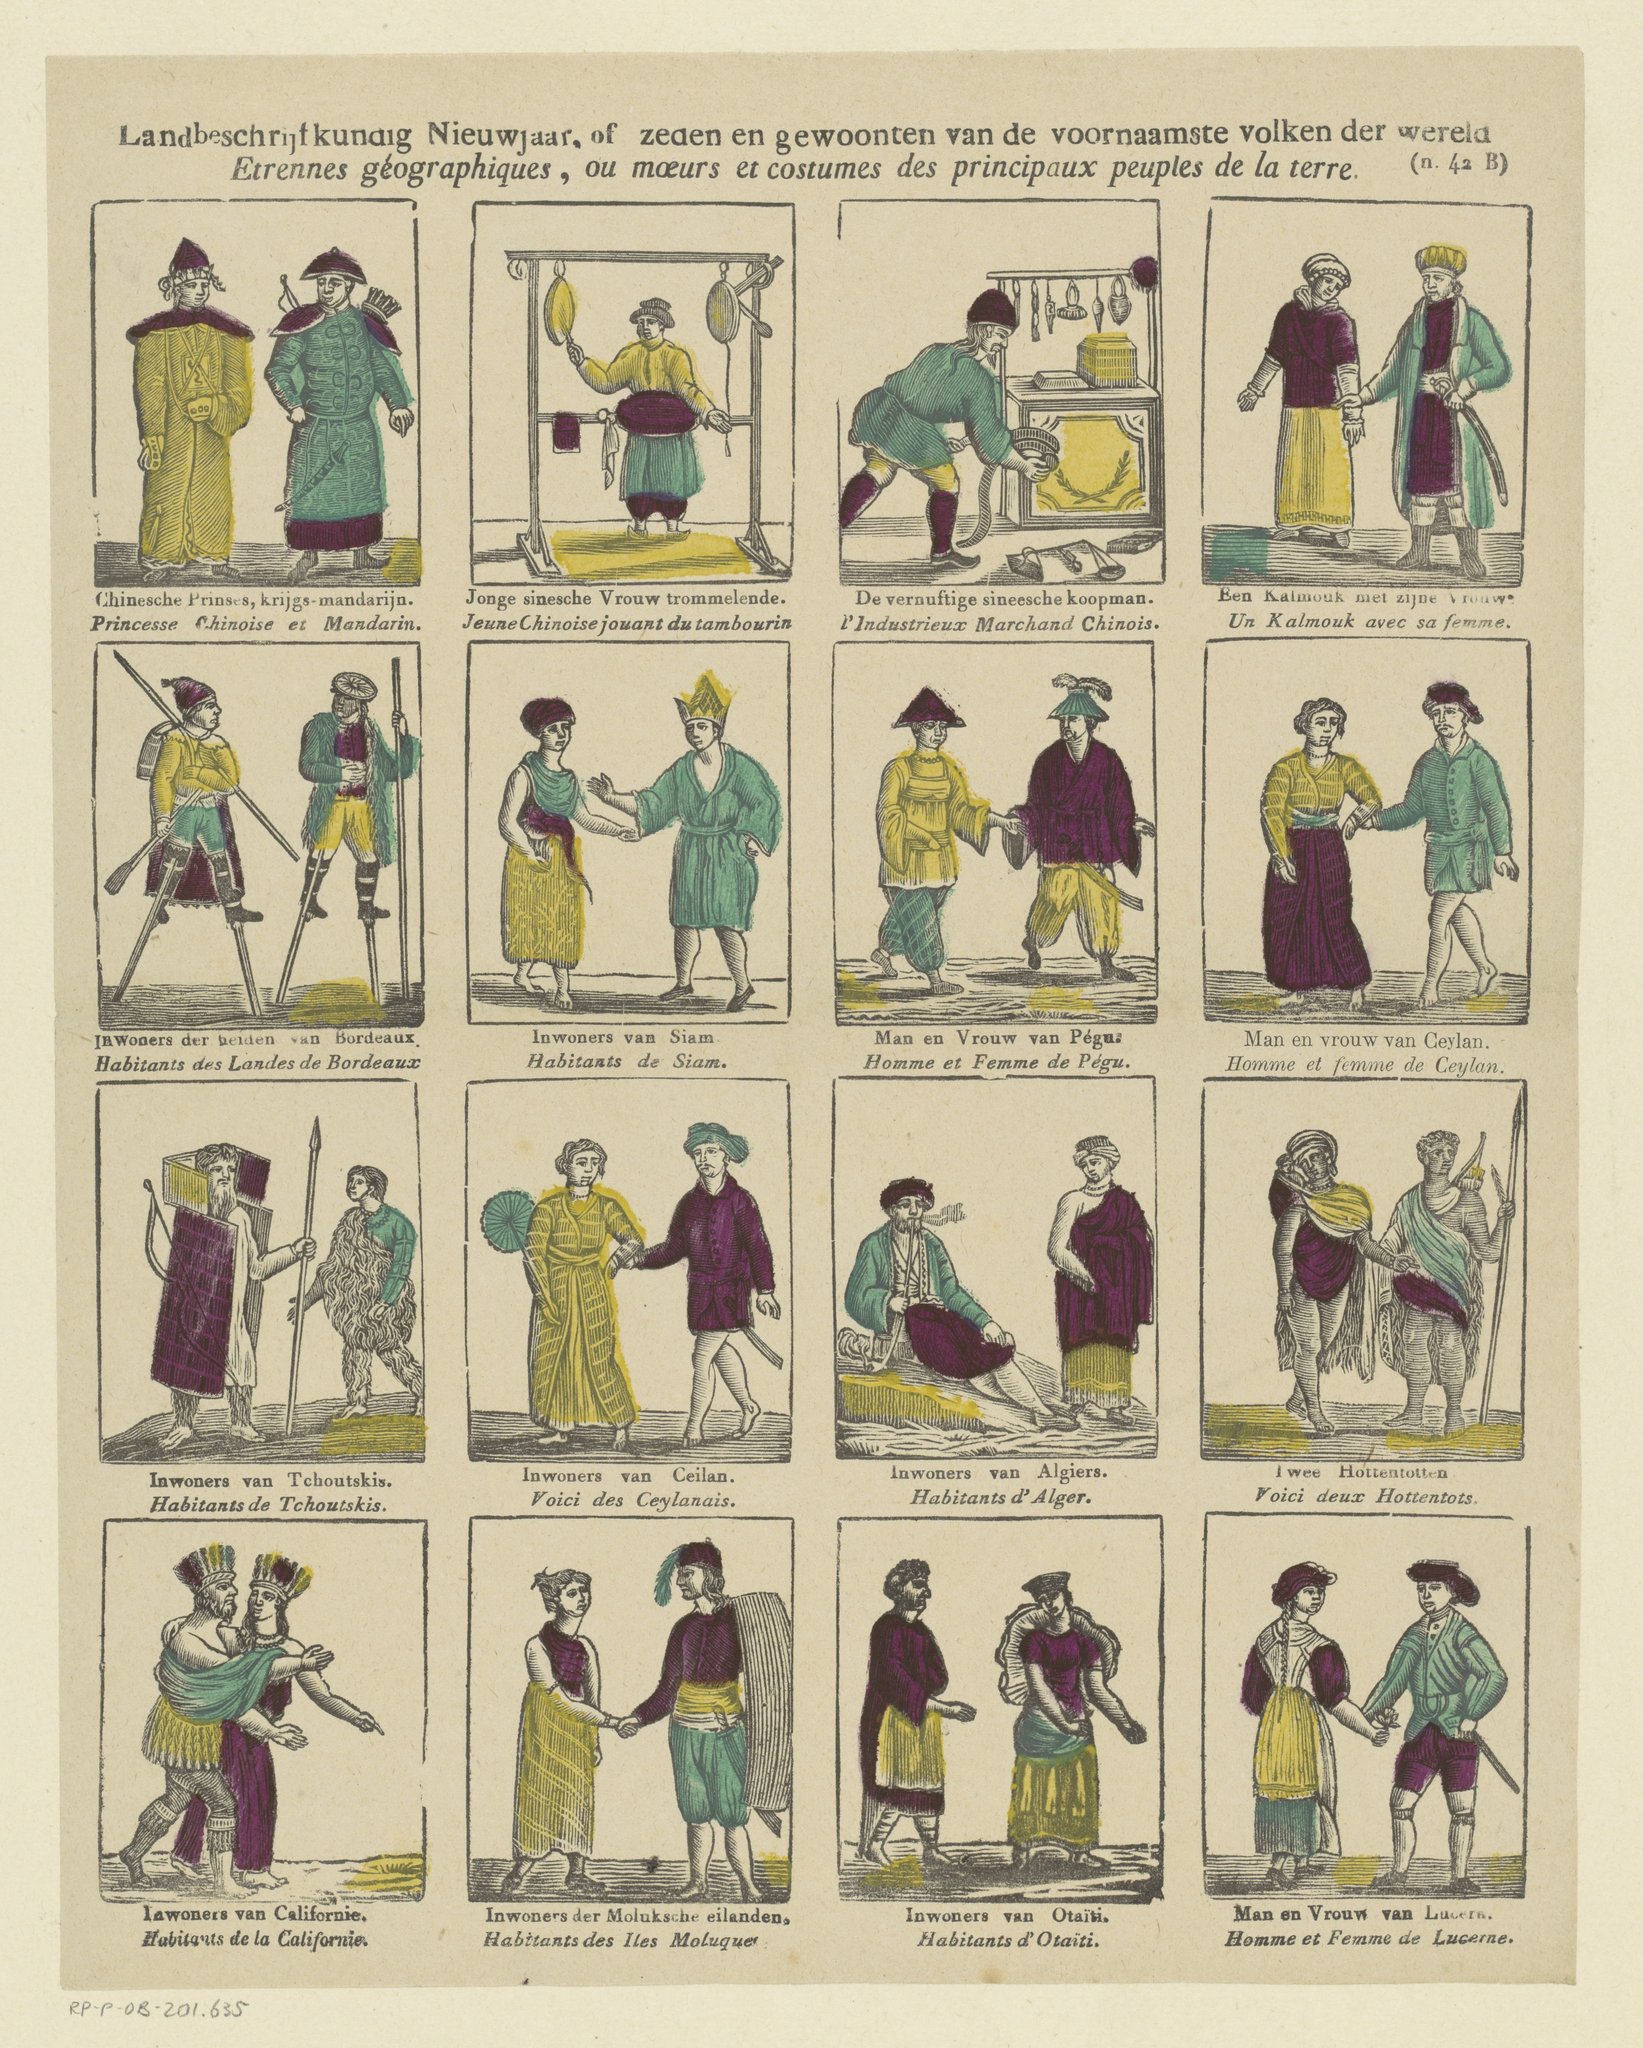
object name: print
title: Landbeschrijfkundig nieuwjaar, of zeden en gewoonten van de voornaamste volken der wereld / Etrennes géographiques, ou moeurs et costumes des principaux peuples de la terre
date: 1800-1833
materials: paper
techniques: colour, letterpress printing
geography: turnhout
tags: asiatic races and peoples, africans, indigenous peoples of north america, historical costume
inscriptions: collector's mark: Lugt 2760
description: Blad met 16 voorstellingen van klederdrachten van verschillende volkeren, waaronder Chinezen, inwoners van Siam, inwoners van Algiers en Khoikhoi. Onder elke voorstelling een onderschrift in het Nederlands en in het Frans. Genummerd rechtsboven: (n. 42 B).